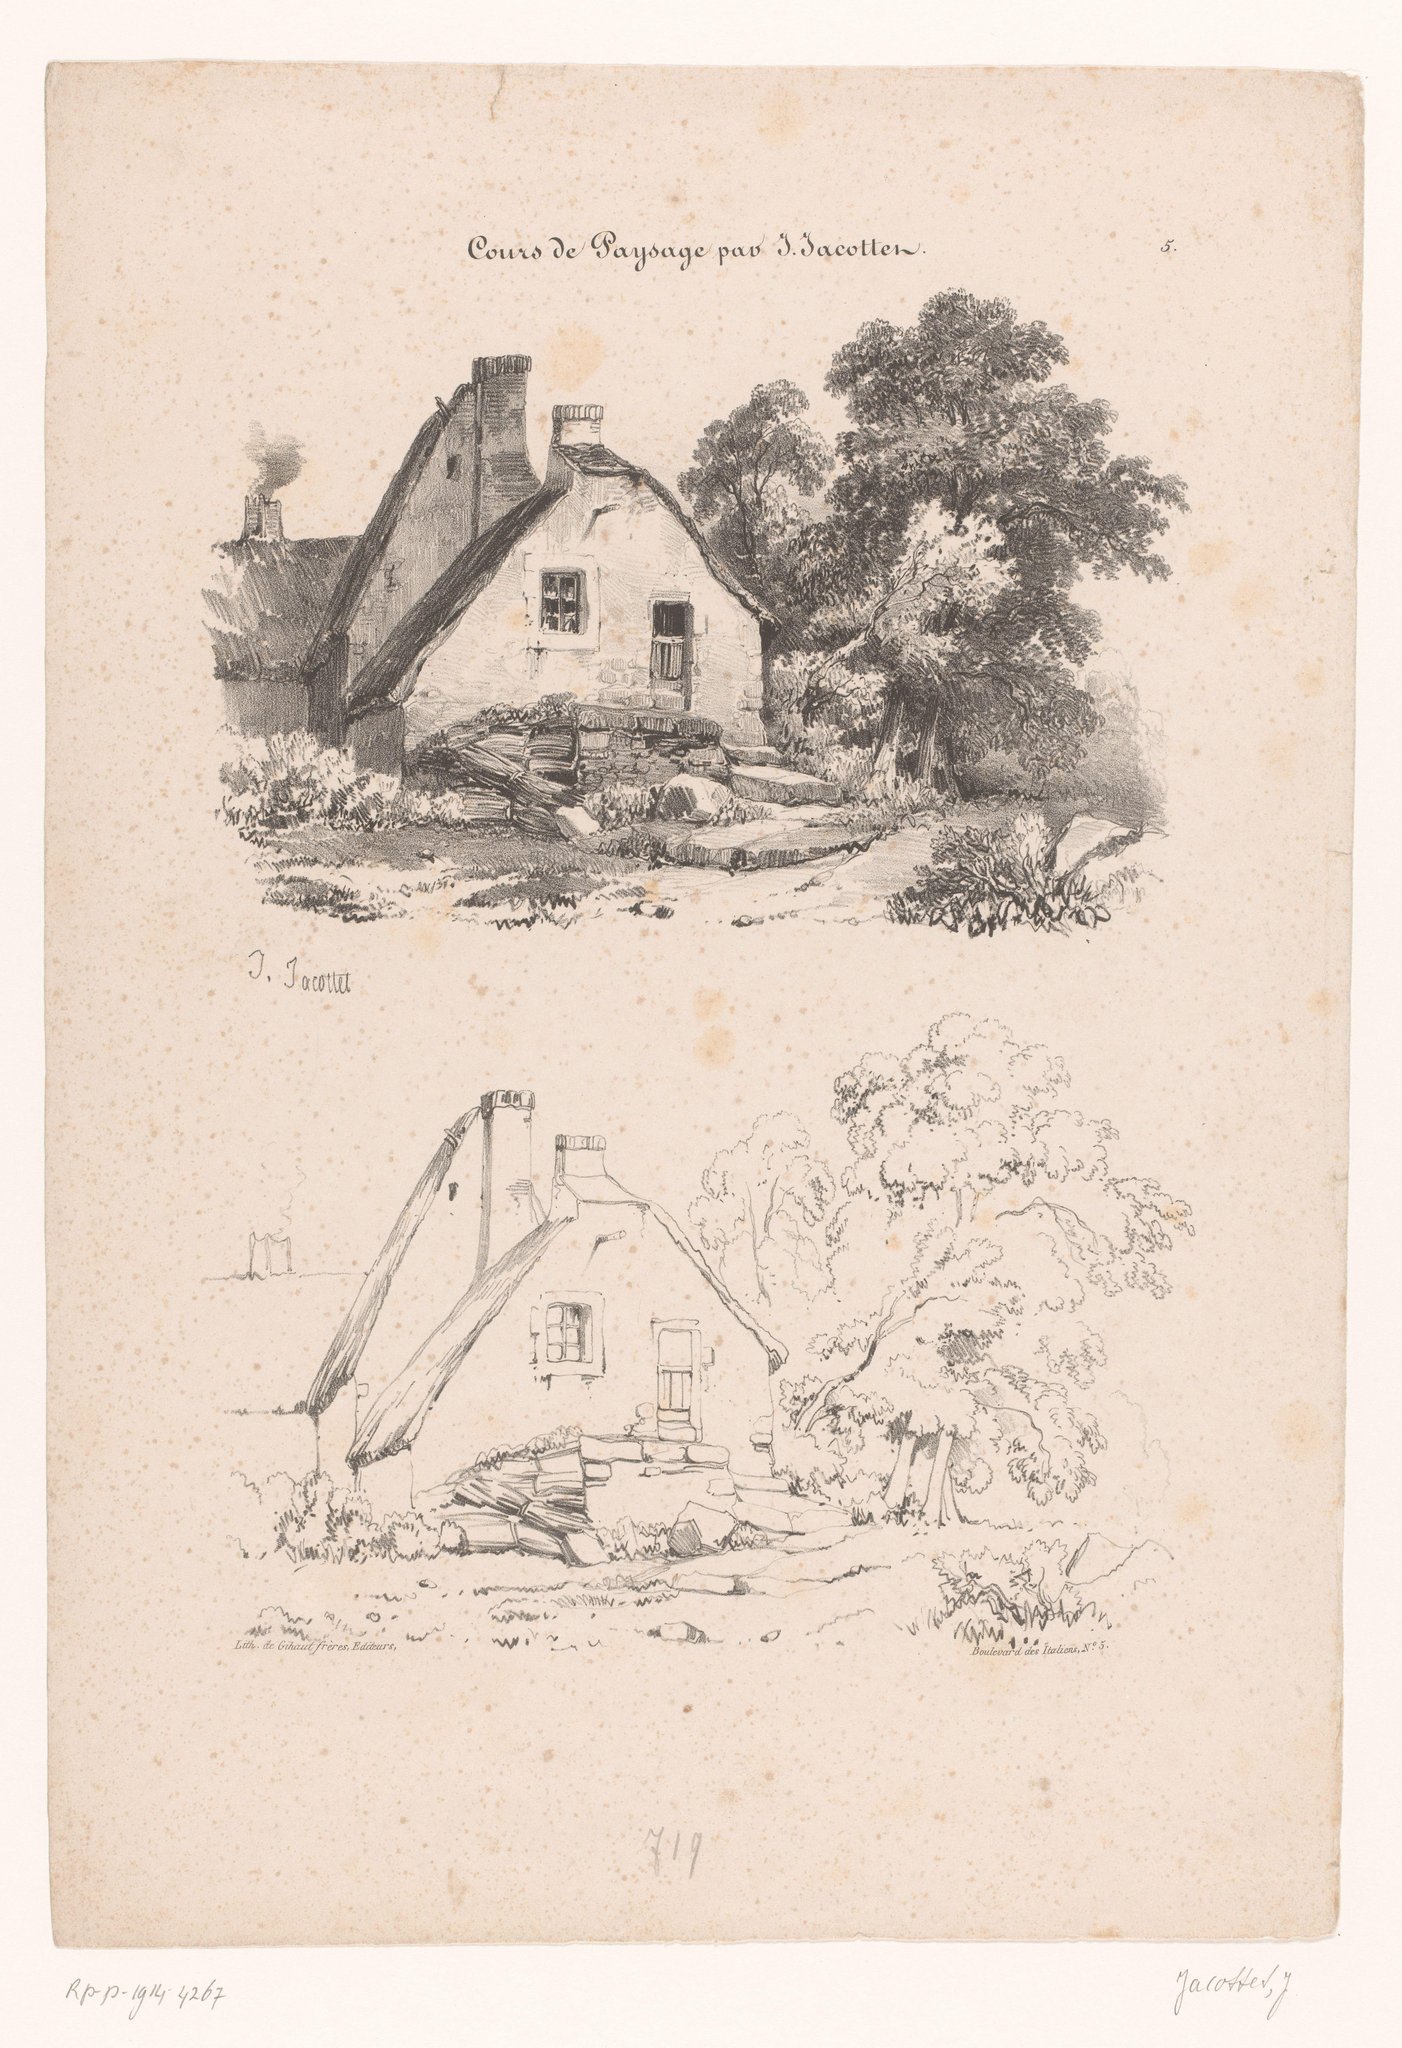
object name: print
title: Cottage met bomen in twee tekenstappen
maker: louis-julien jacottet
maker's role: painter, print maker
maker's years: 1806-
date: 1836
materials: paper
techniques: lithograph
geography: paris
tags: cottage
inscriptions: collector's mark: Lugt 2228a